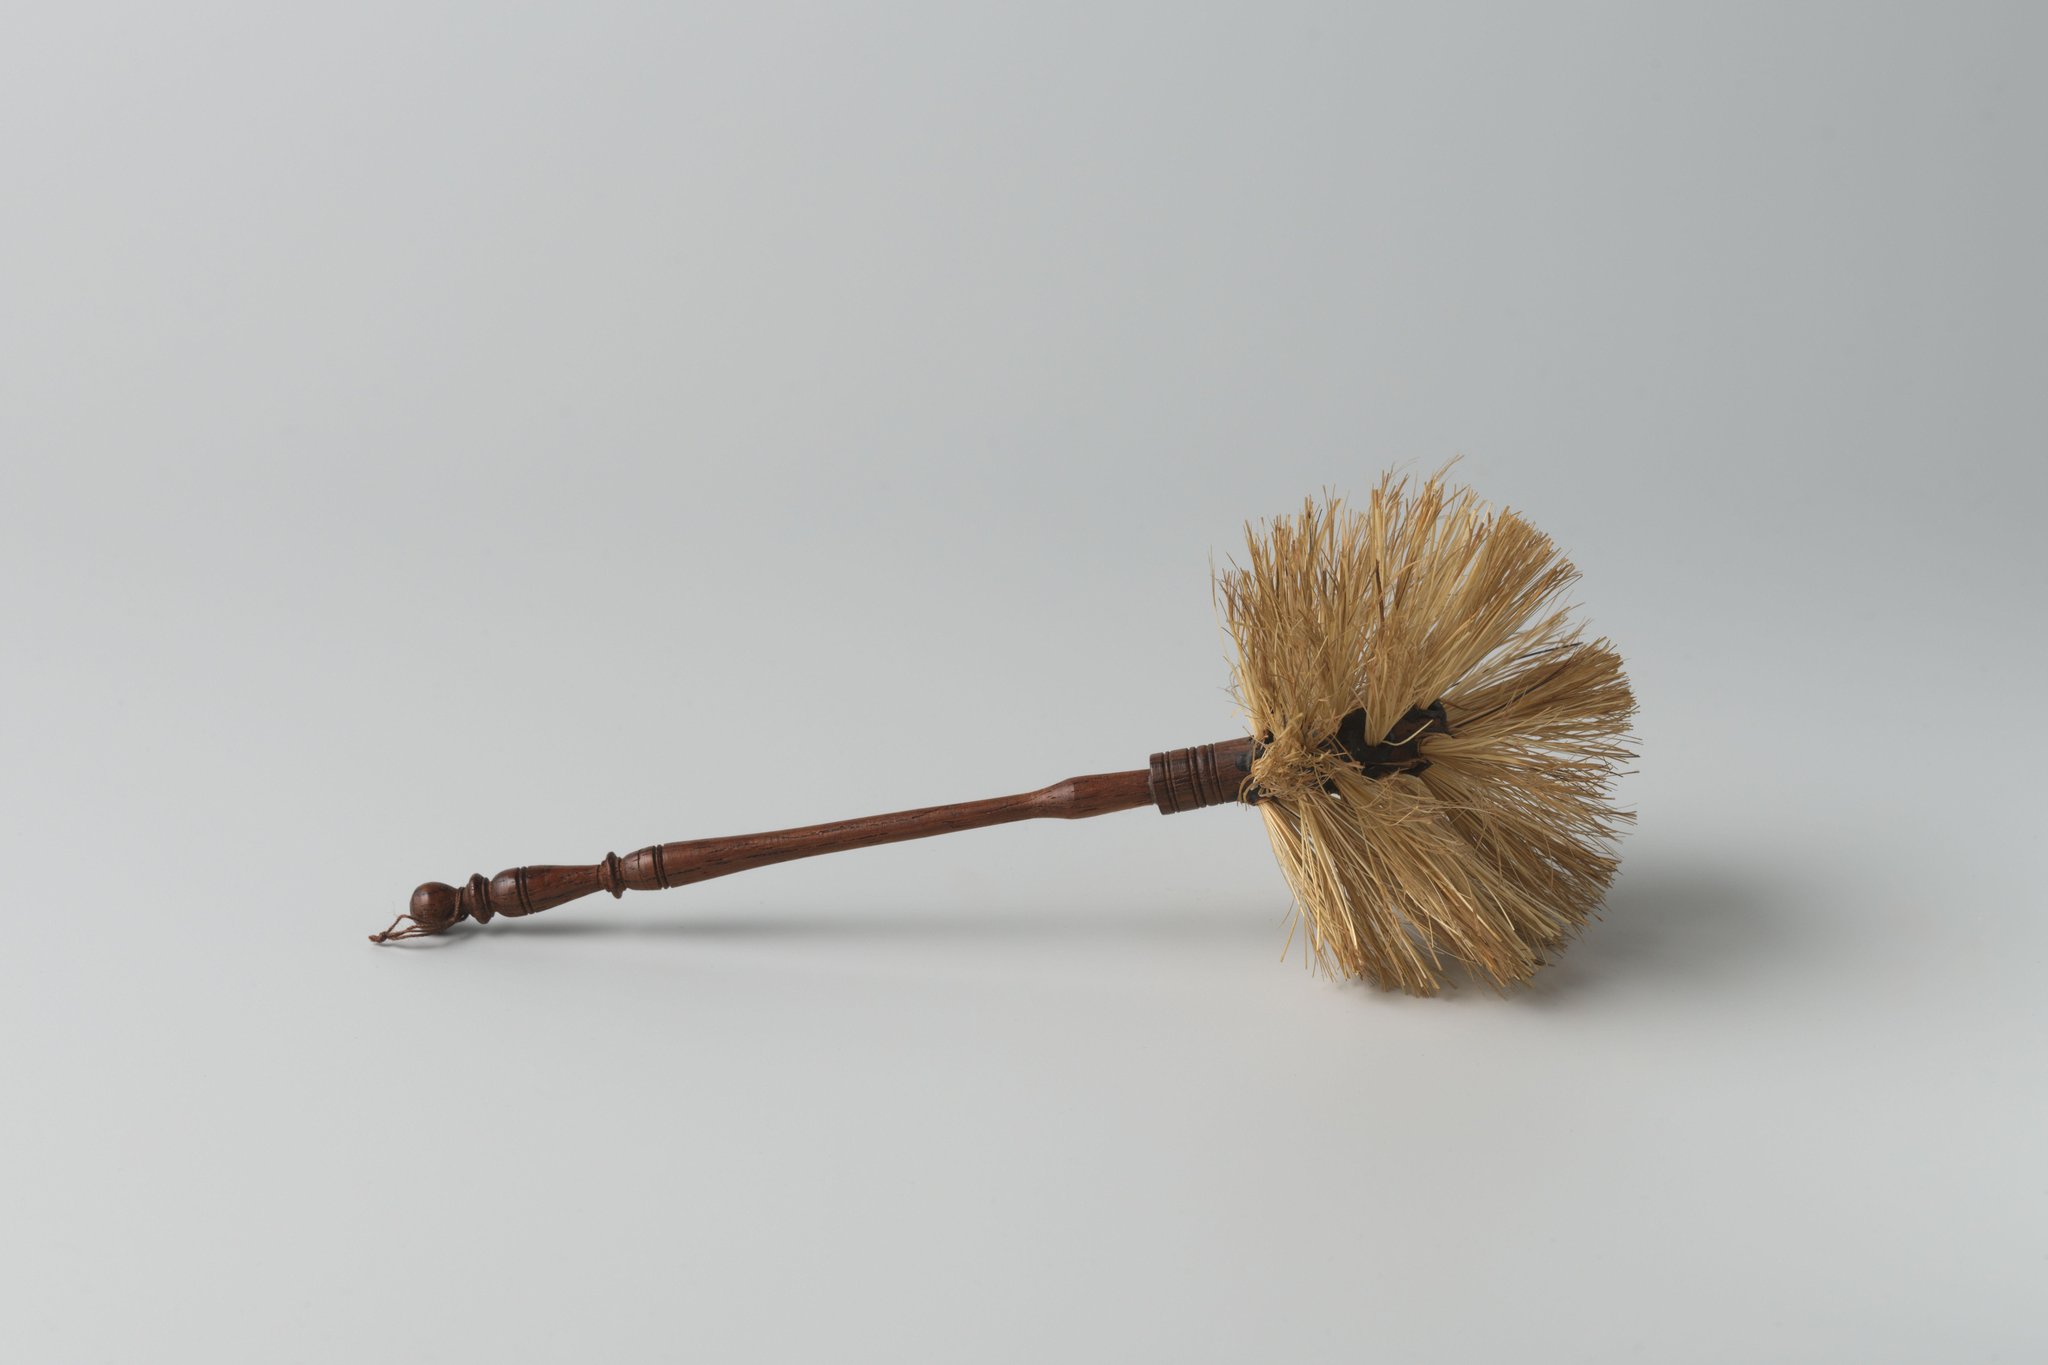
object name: cobweb broom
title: Ragebol van palissanderhout en varkenshaar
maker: Anonymous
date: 1676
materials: wood, silk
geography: amsterdam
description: Ragebol van palissanderhout en varkenshaar. De ragebol heeft een langwerpige ronde kop, waarin rondom haar is ingezet, en een lange geprofileerde steel met knop, waaraan resten van een roze zijden lint.